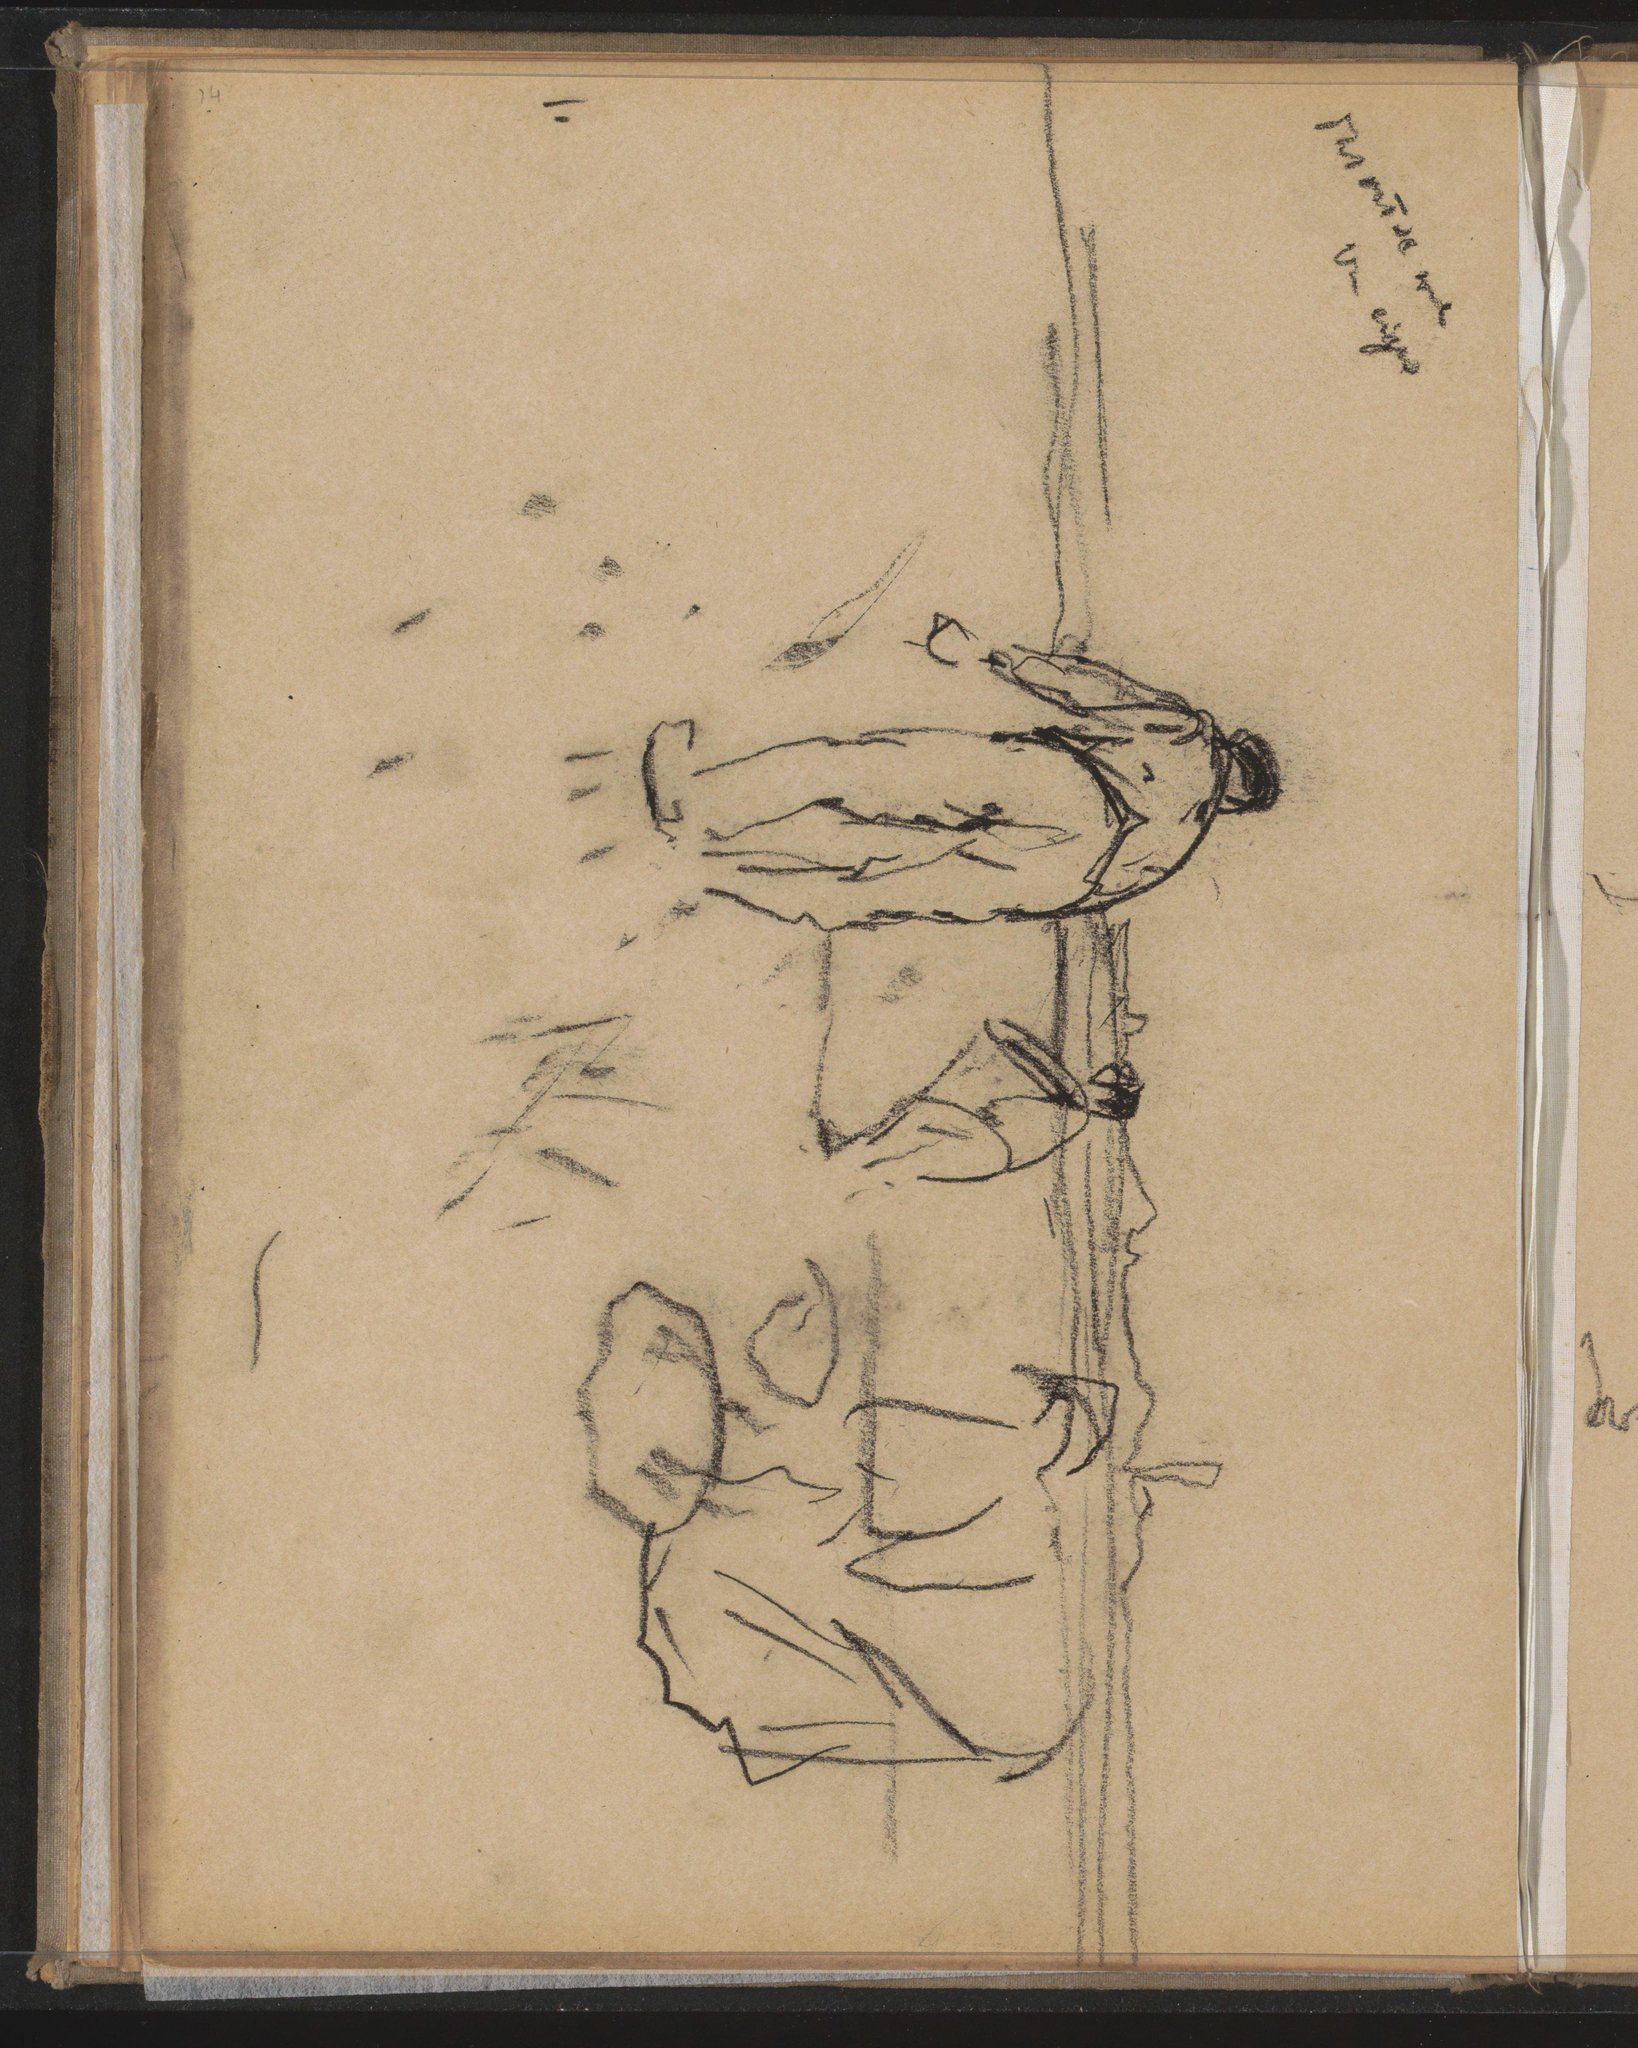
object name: sketchbook leaf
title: Figuren aan het werk op het land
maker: willem witsen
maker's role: draughtsman, painter, print maker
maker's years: 1860-1923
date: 1893-1897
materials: chalk, paper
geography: ede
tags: farmers, cultivated land (+ landscape with figures, staffage)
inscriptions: annotation: ‘[...]’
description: Pagina 14 uit een schetsboek met 25 bladen.